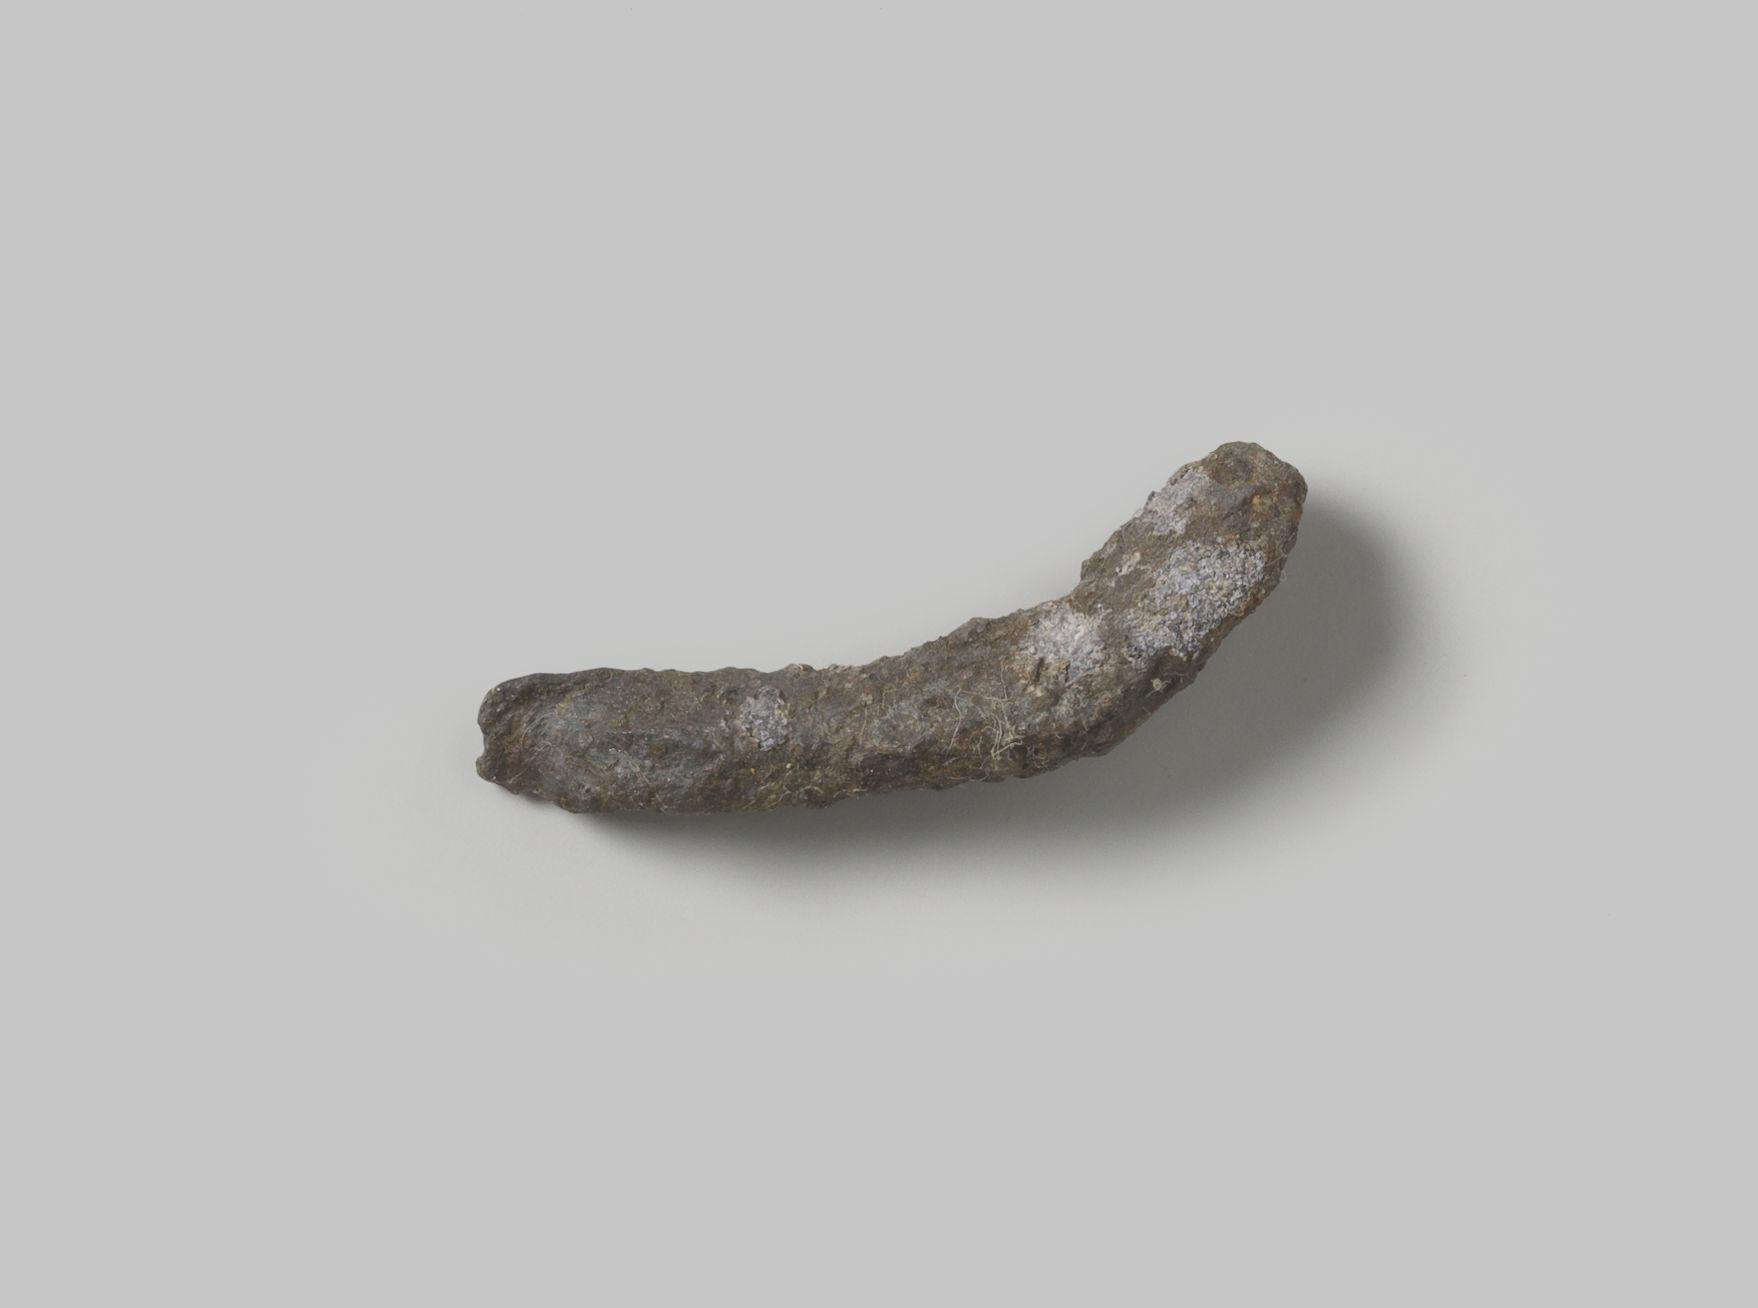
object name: buckle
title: Fragment gesp uit het wrak van de Oostindiëvaarder Hollandia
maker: Anonymous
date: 1700-1743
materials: tin